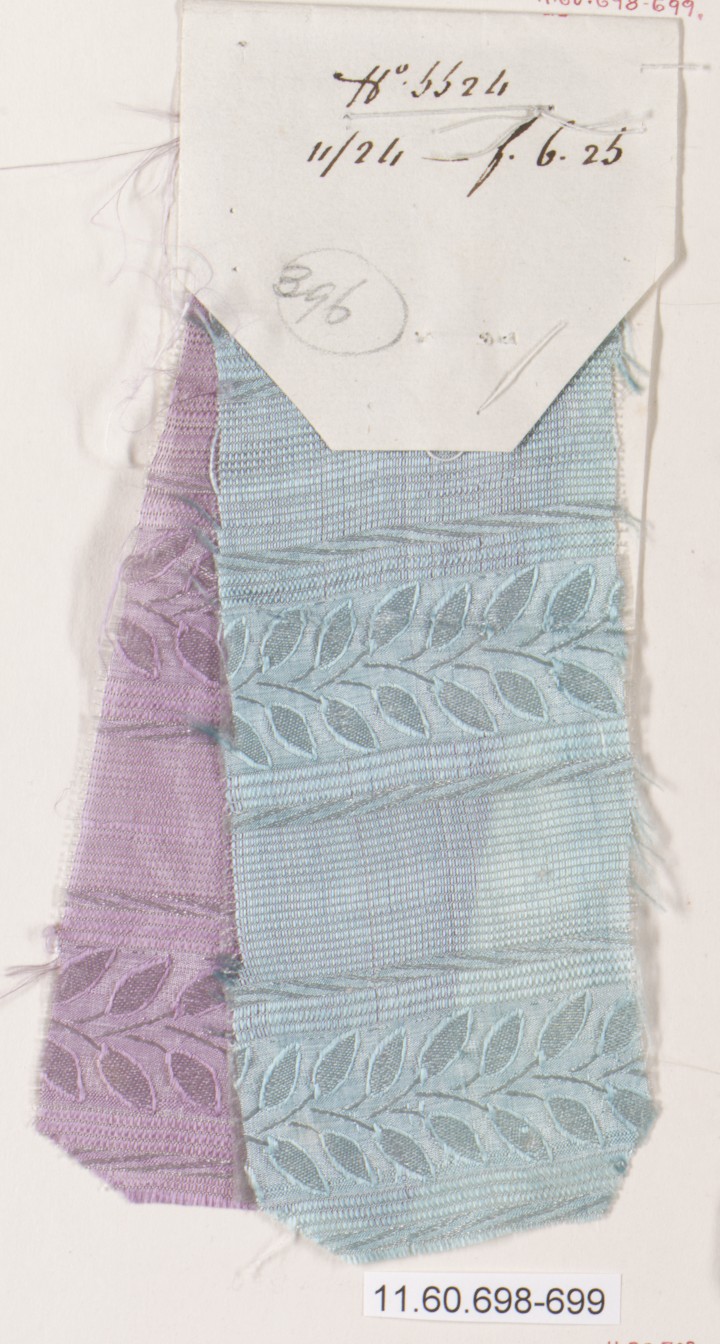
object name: sample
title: Samples (2)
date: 1801-1850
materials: silk